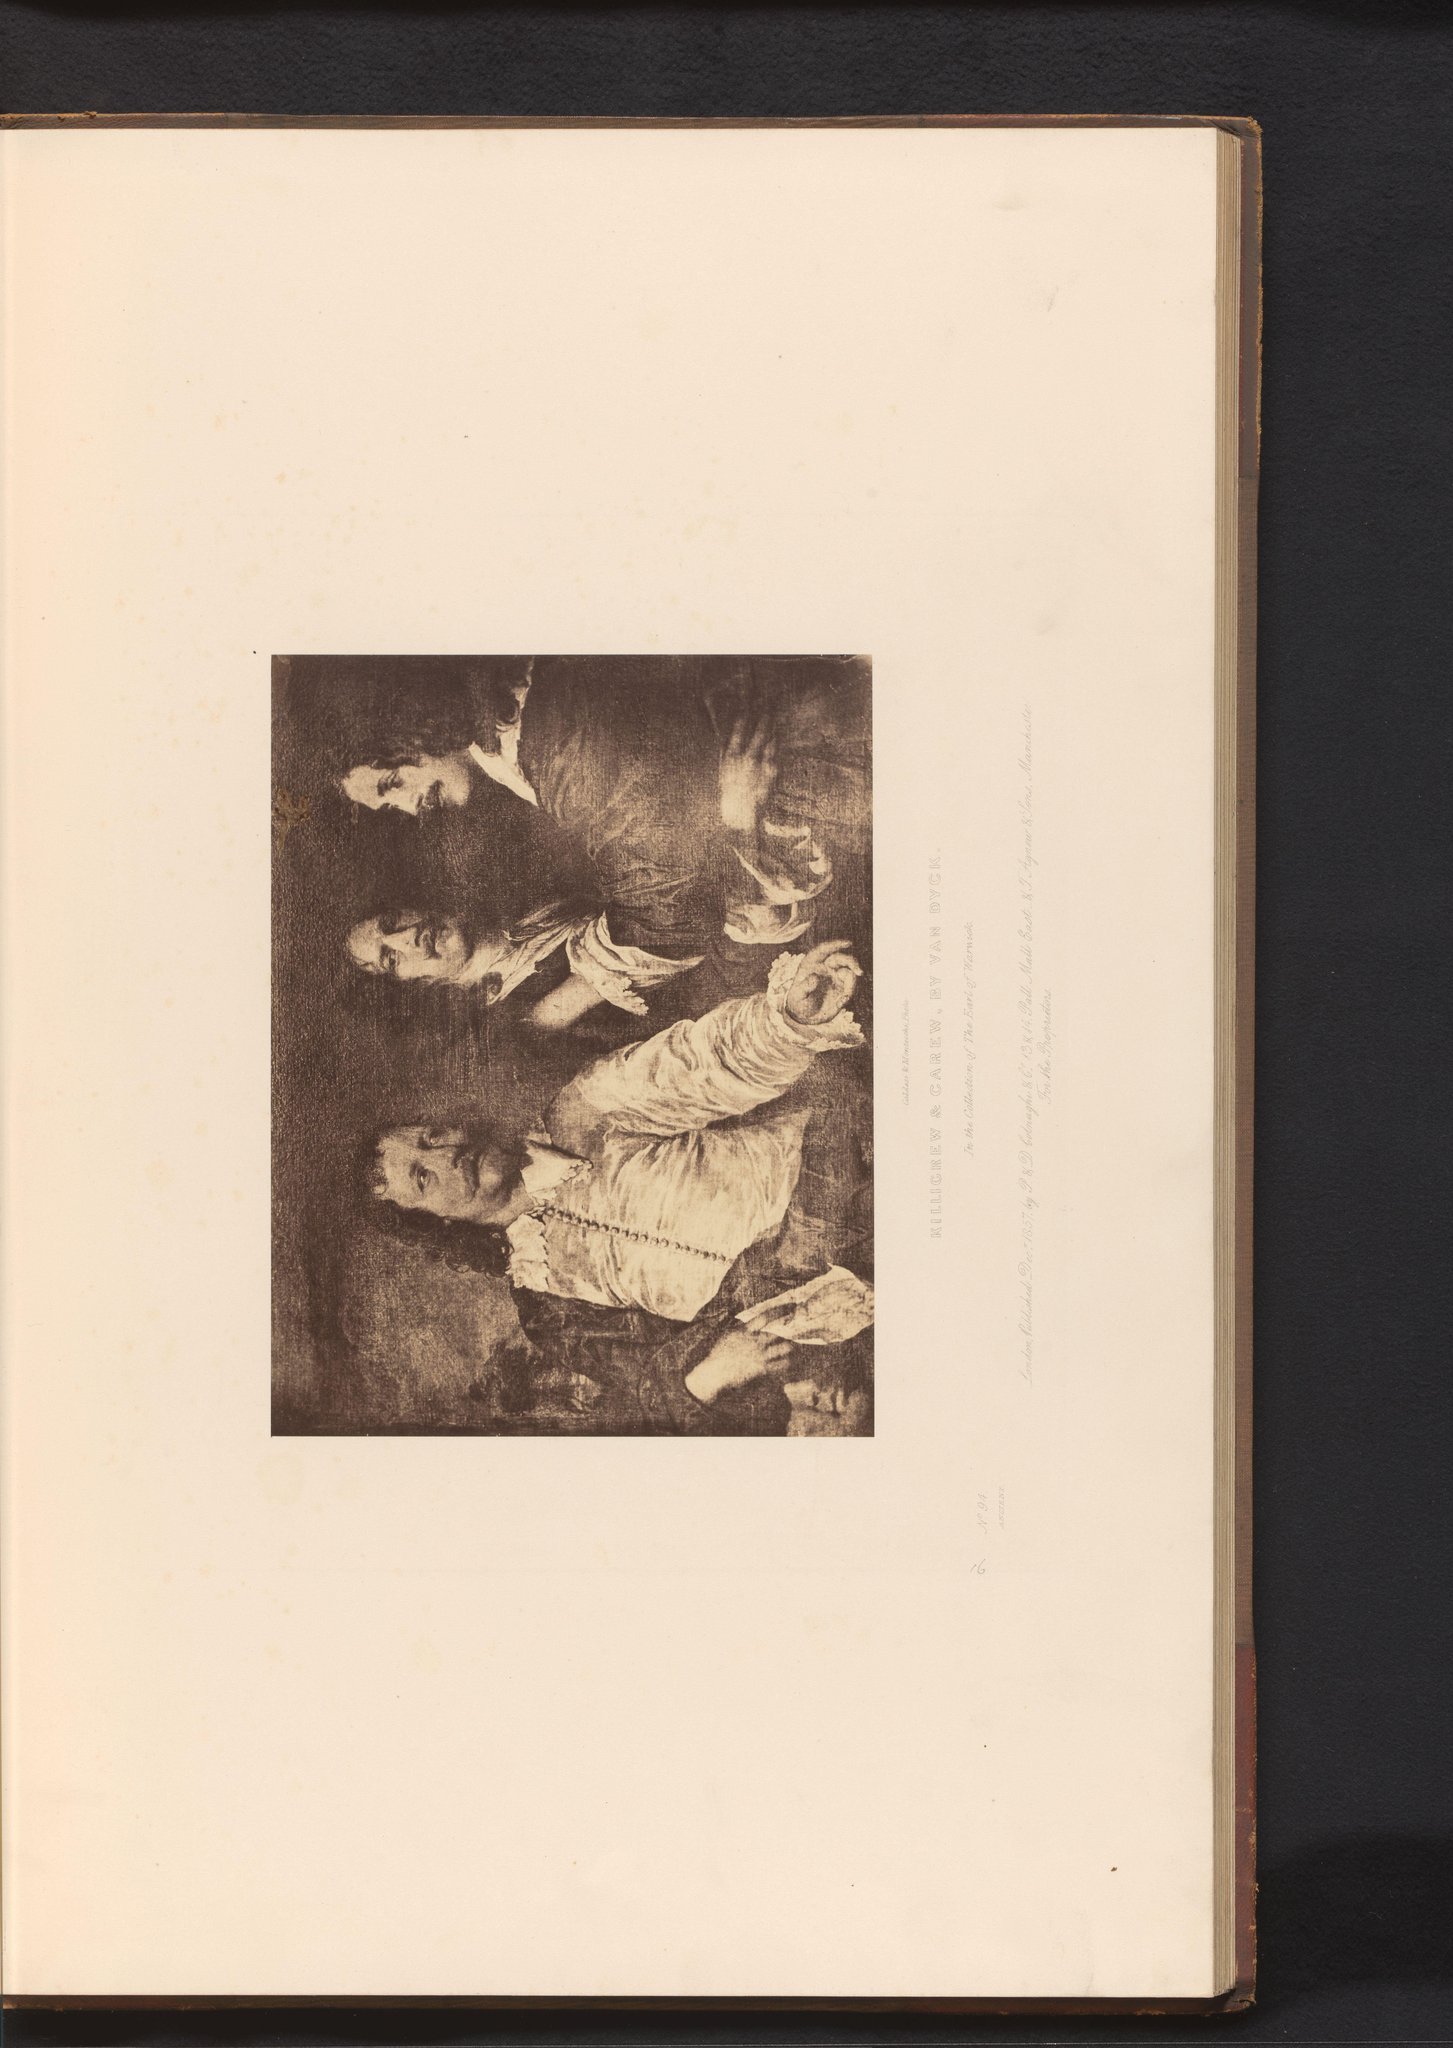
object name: photograph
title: Fotoreproductie van een schilderij van een portret van Thomas Killigrew en Thomas Carew door Anthony van Dyck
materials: photographic support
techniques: albumen print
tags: historical persons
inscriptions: number: ‘No. 94./ ANCIENT.’, inscription: ‘In the Collection of The Earl of Warwick./ London, Published Decr, 1857, by P. & D. Colnaghi & Co, 13 & 14, Pall Mall East & T. Agneur & Sons, Manchester./ For the Proprietors.’, number: ‘16’